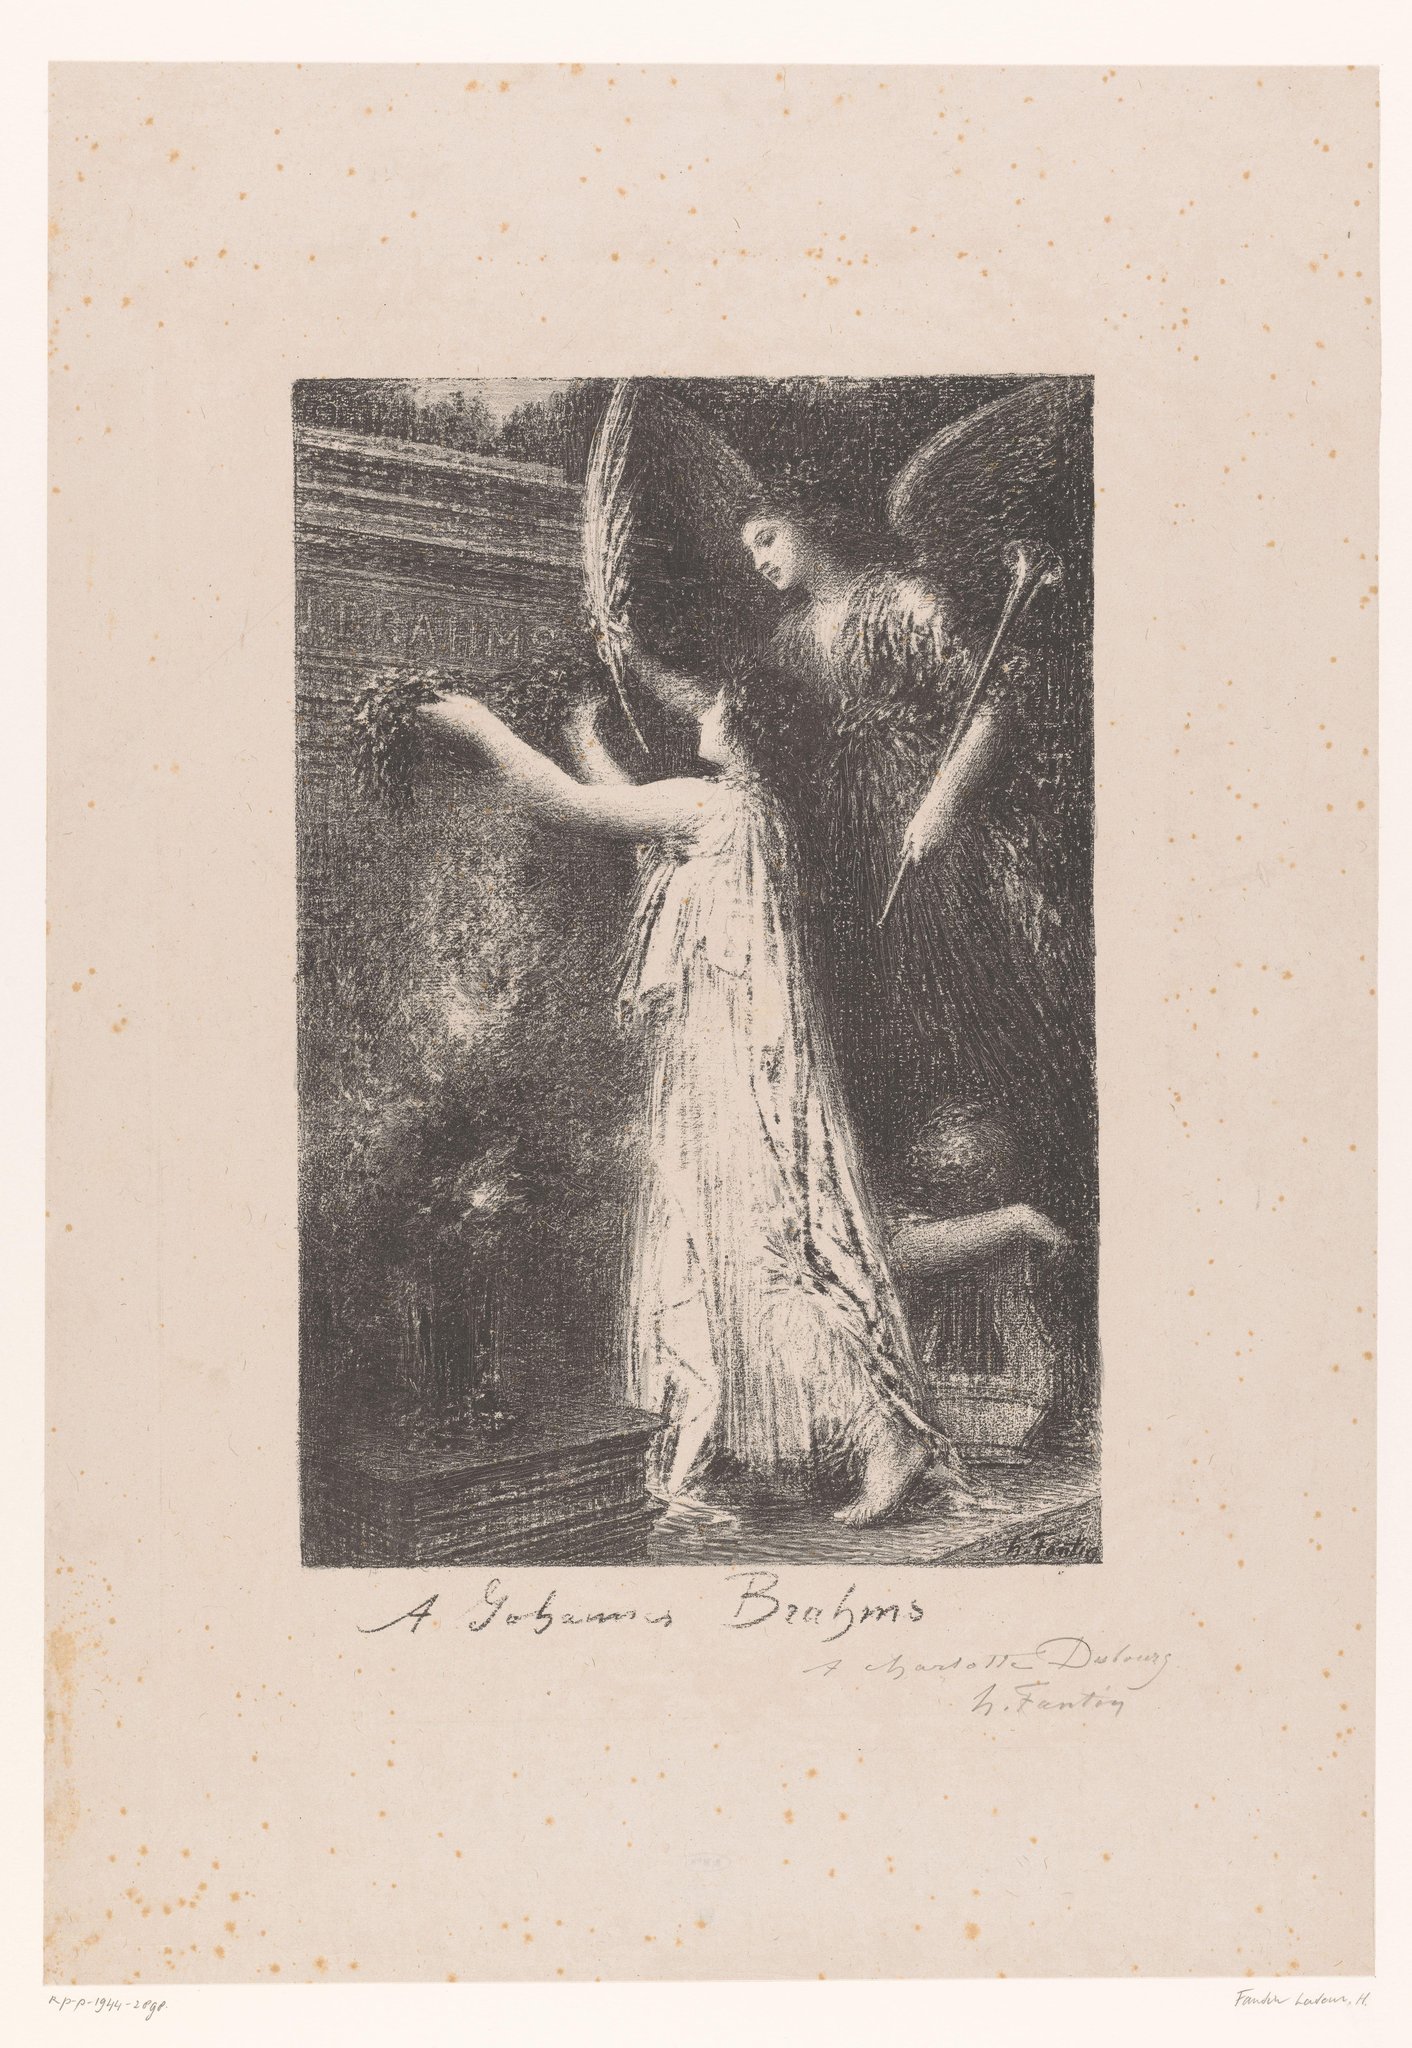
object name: print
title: Engel en personificatie van de roem brengen erekrans bij graftombe van Johannes Brahms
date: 1900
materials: paper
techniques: lithography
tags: vienna, johannes brahms, honouring the artist with laurel wreath, laying flowers or wreath on grave, historical persons, fame; 'fama', 'fama buona', 'fama chiara' (ripa)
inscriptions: collector's mark: Lugt 2760, collector's mark: Lugt 2228a